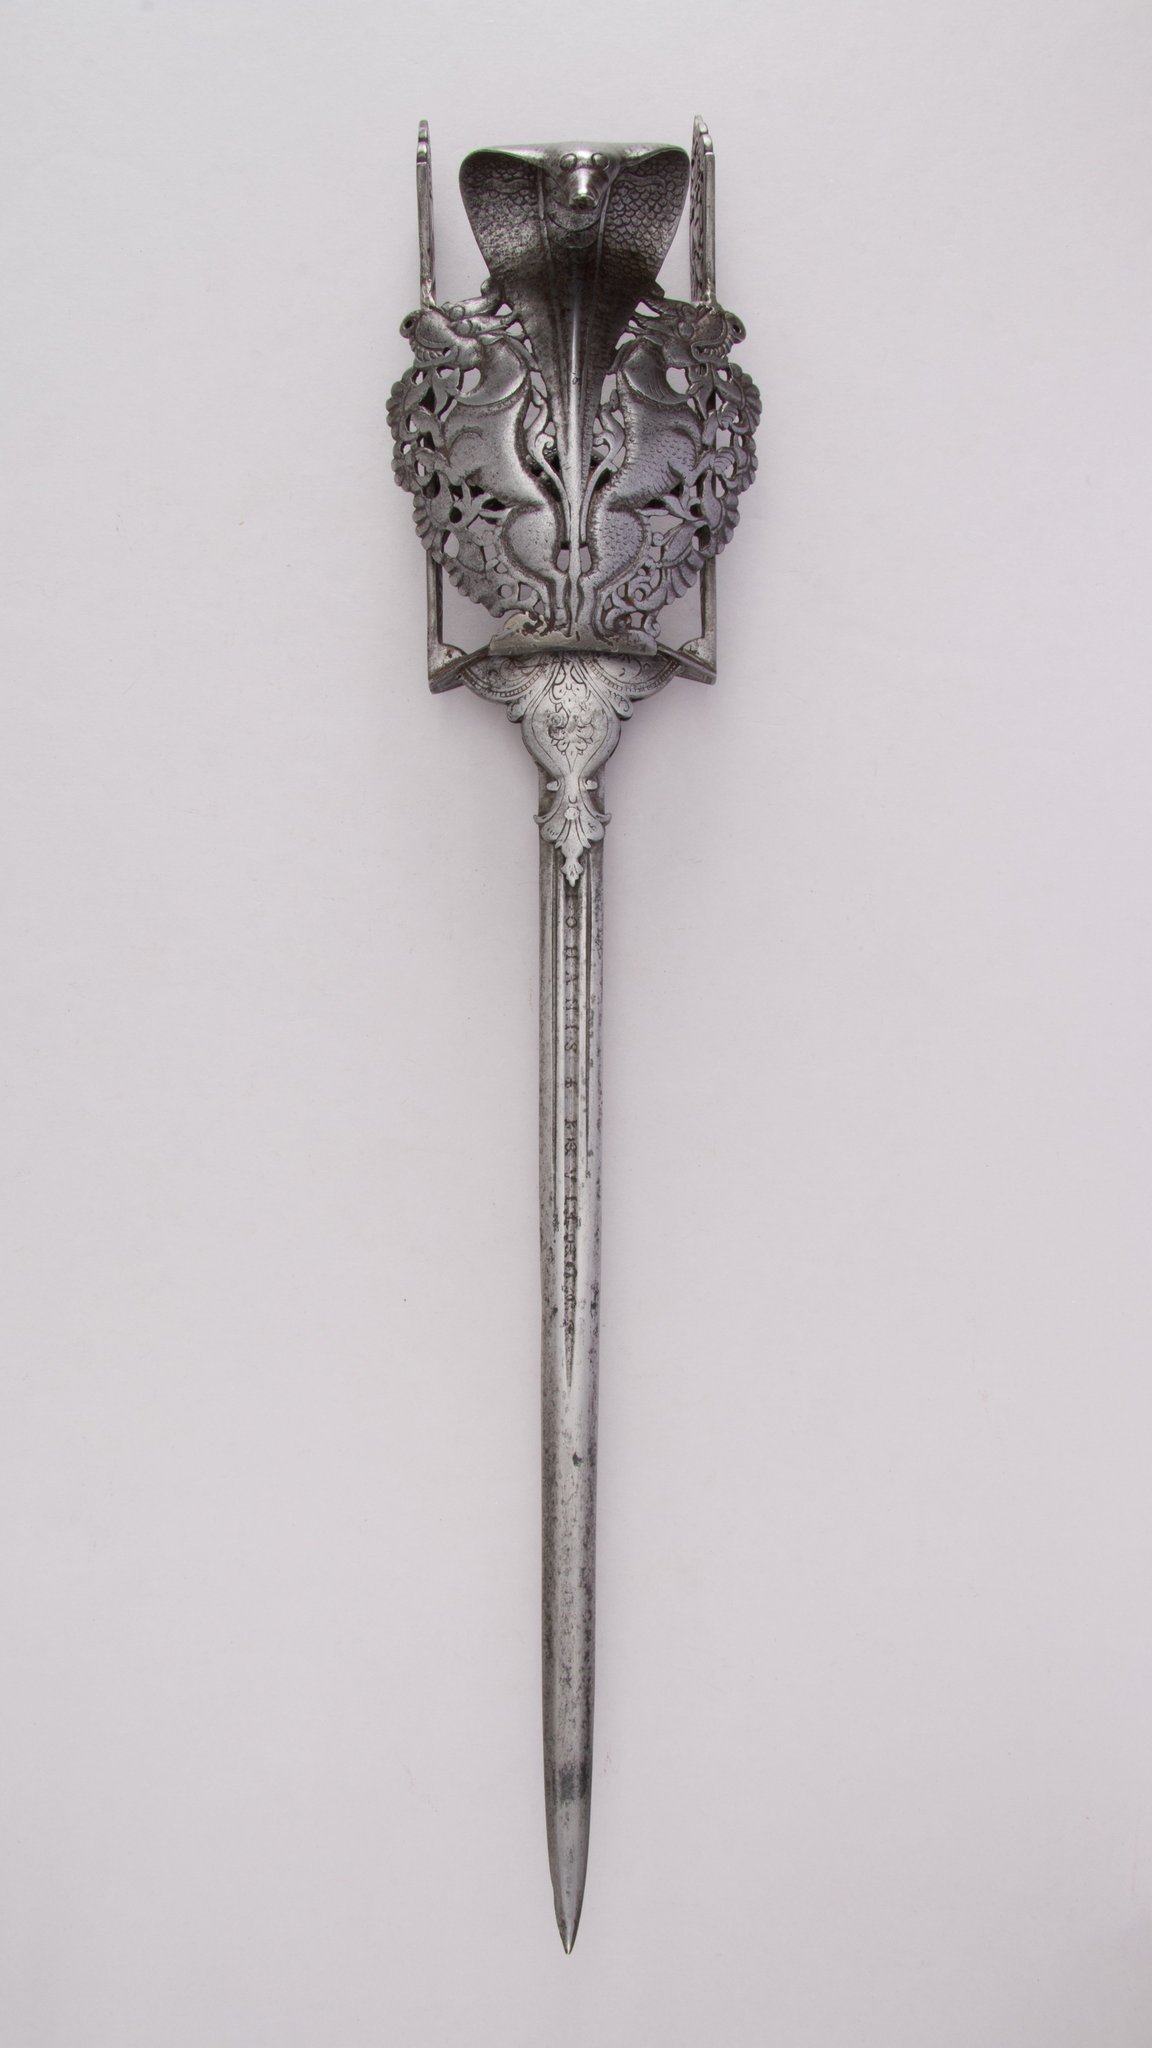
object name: dagger katar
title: Guarded Dagger (Katar)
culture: indian or european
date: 1501-1600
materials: steel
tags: snakes